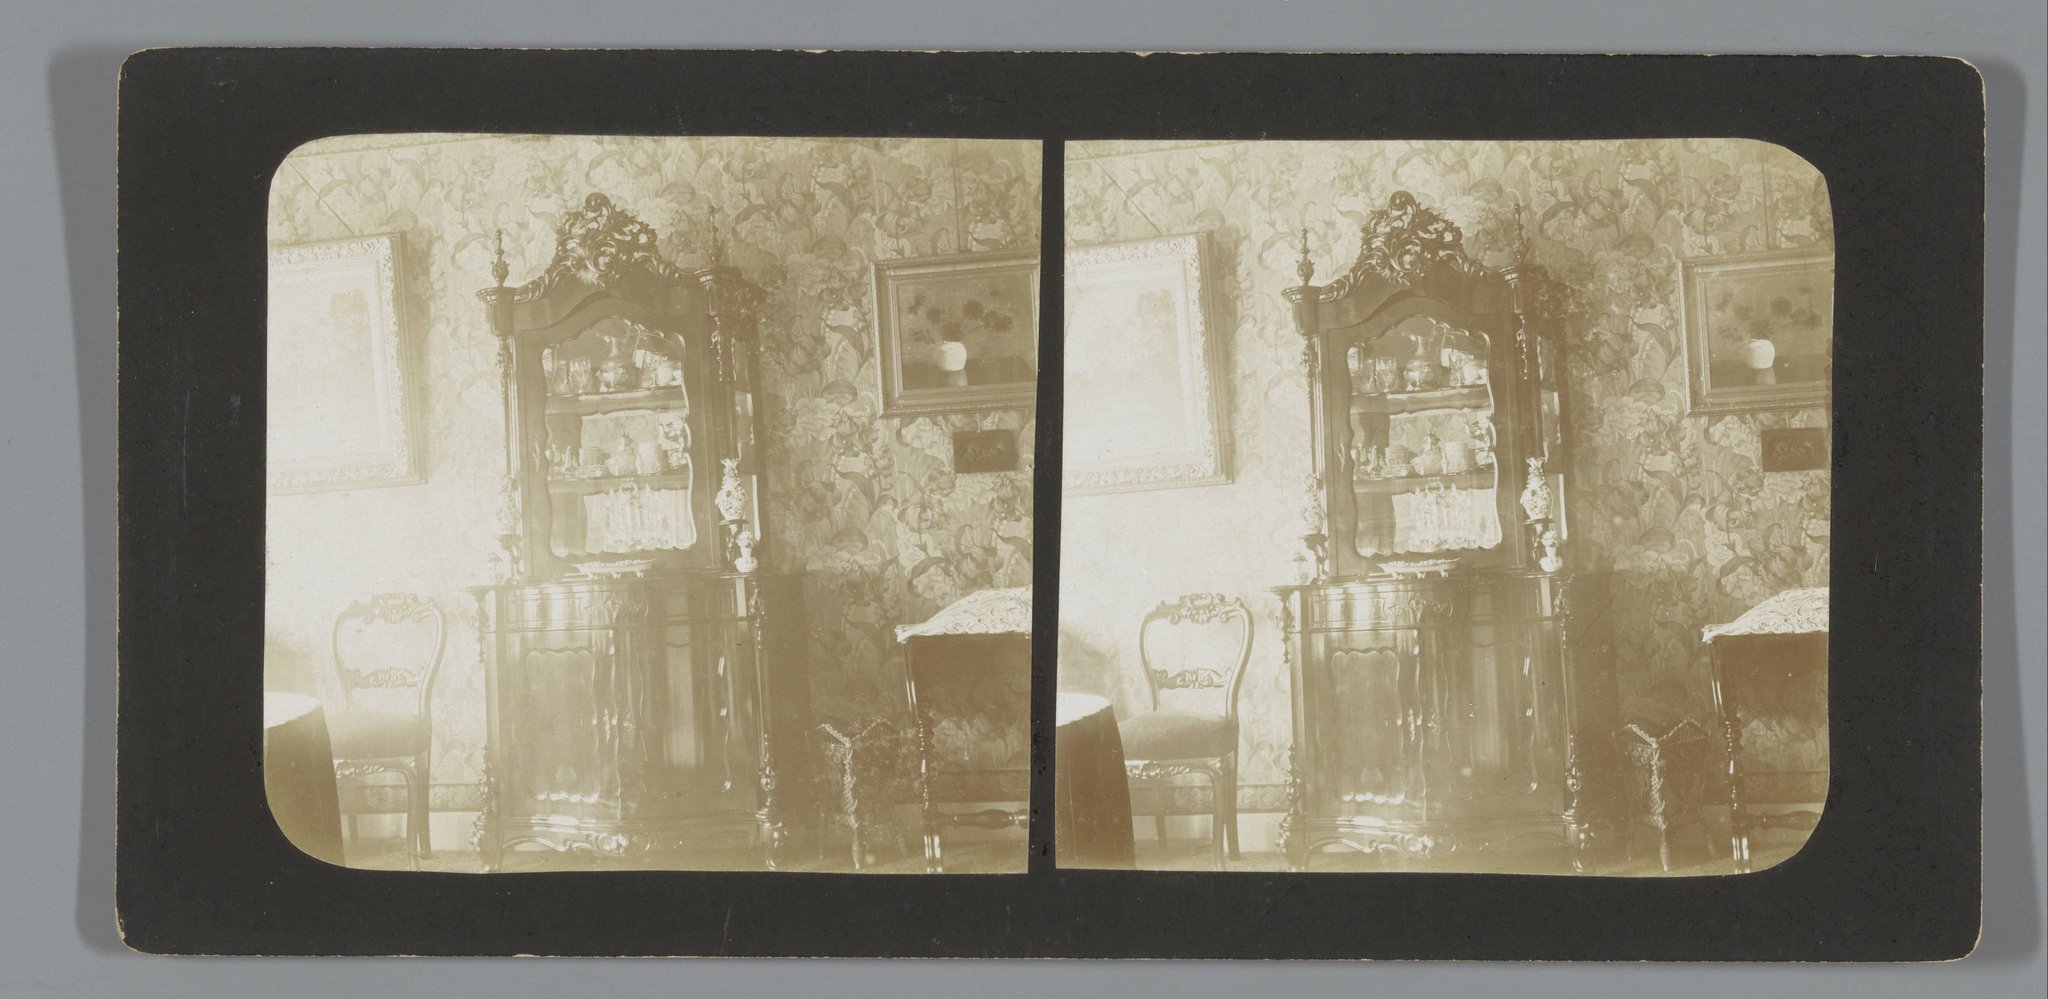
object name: stereograph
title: Kast in de voorkamer in het huis aan het Singel 256, Amsterdam, Nederland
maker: adrianus scheltema-beduin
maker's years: 1864-1944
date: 1899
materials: paper, cardboard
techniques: collodion silver print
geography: amsterdam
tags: ornamental cupboard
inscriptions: inscription: ‘Kastje op de Voorkamer/ vroeger op de Zaal./ 22 Oct 99.’